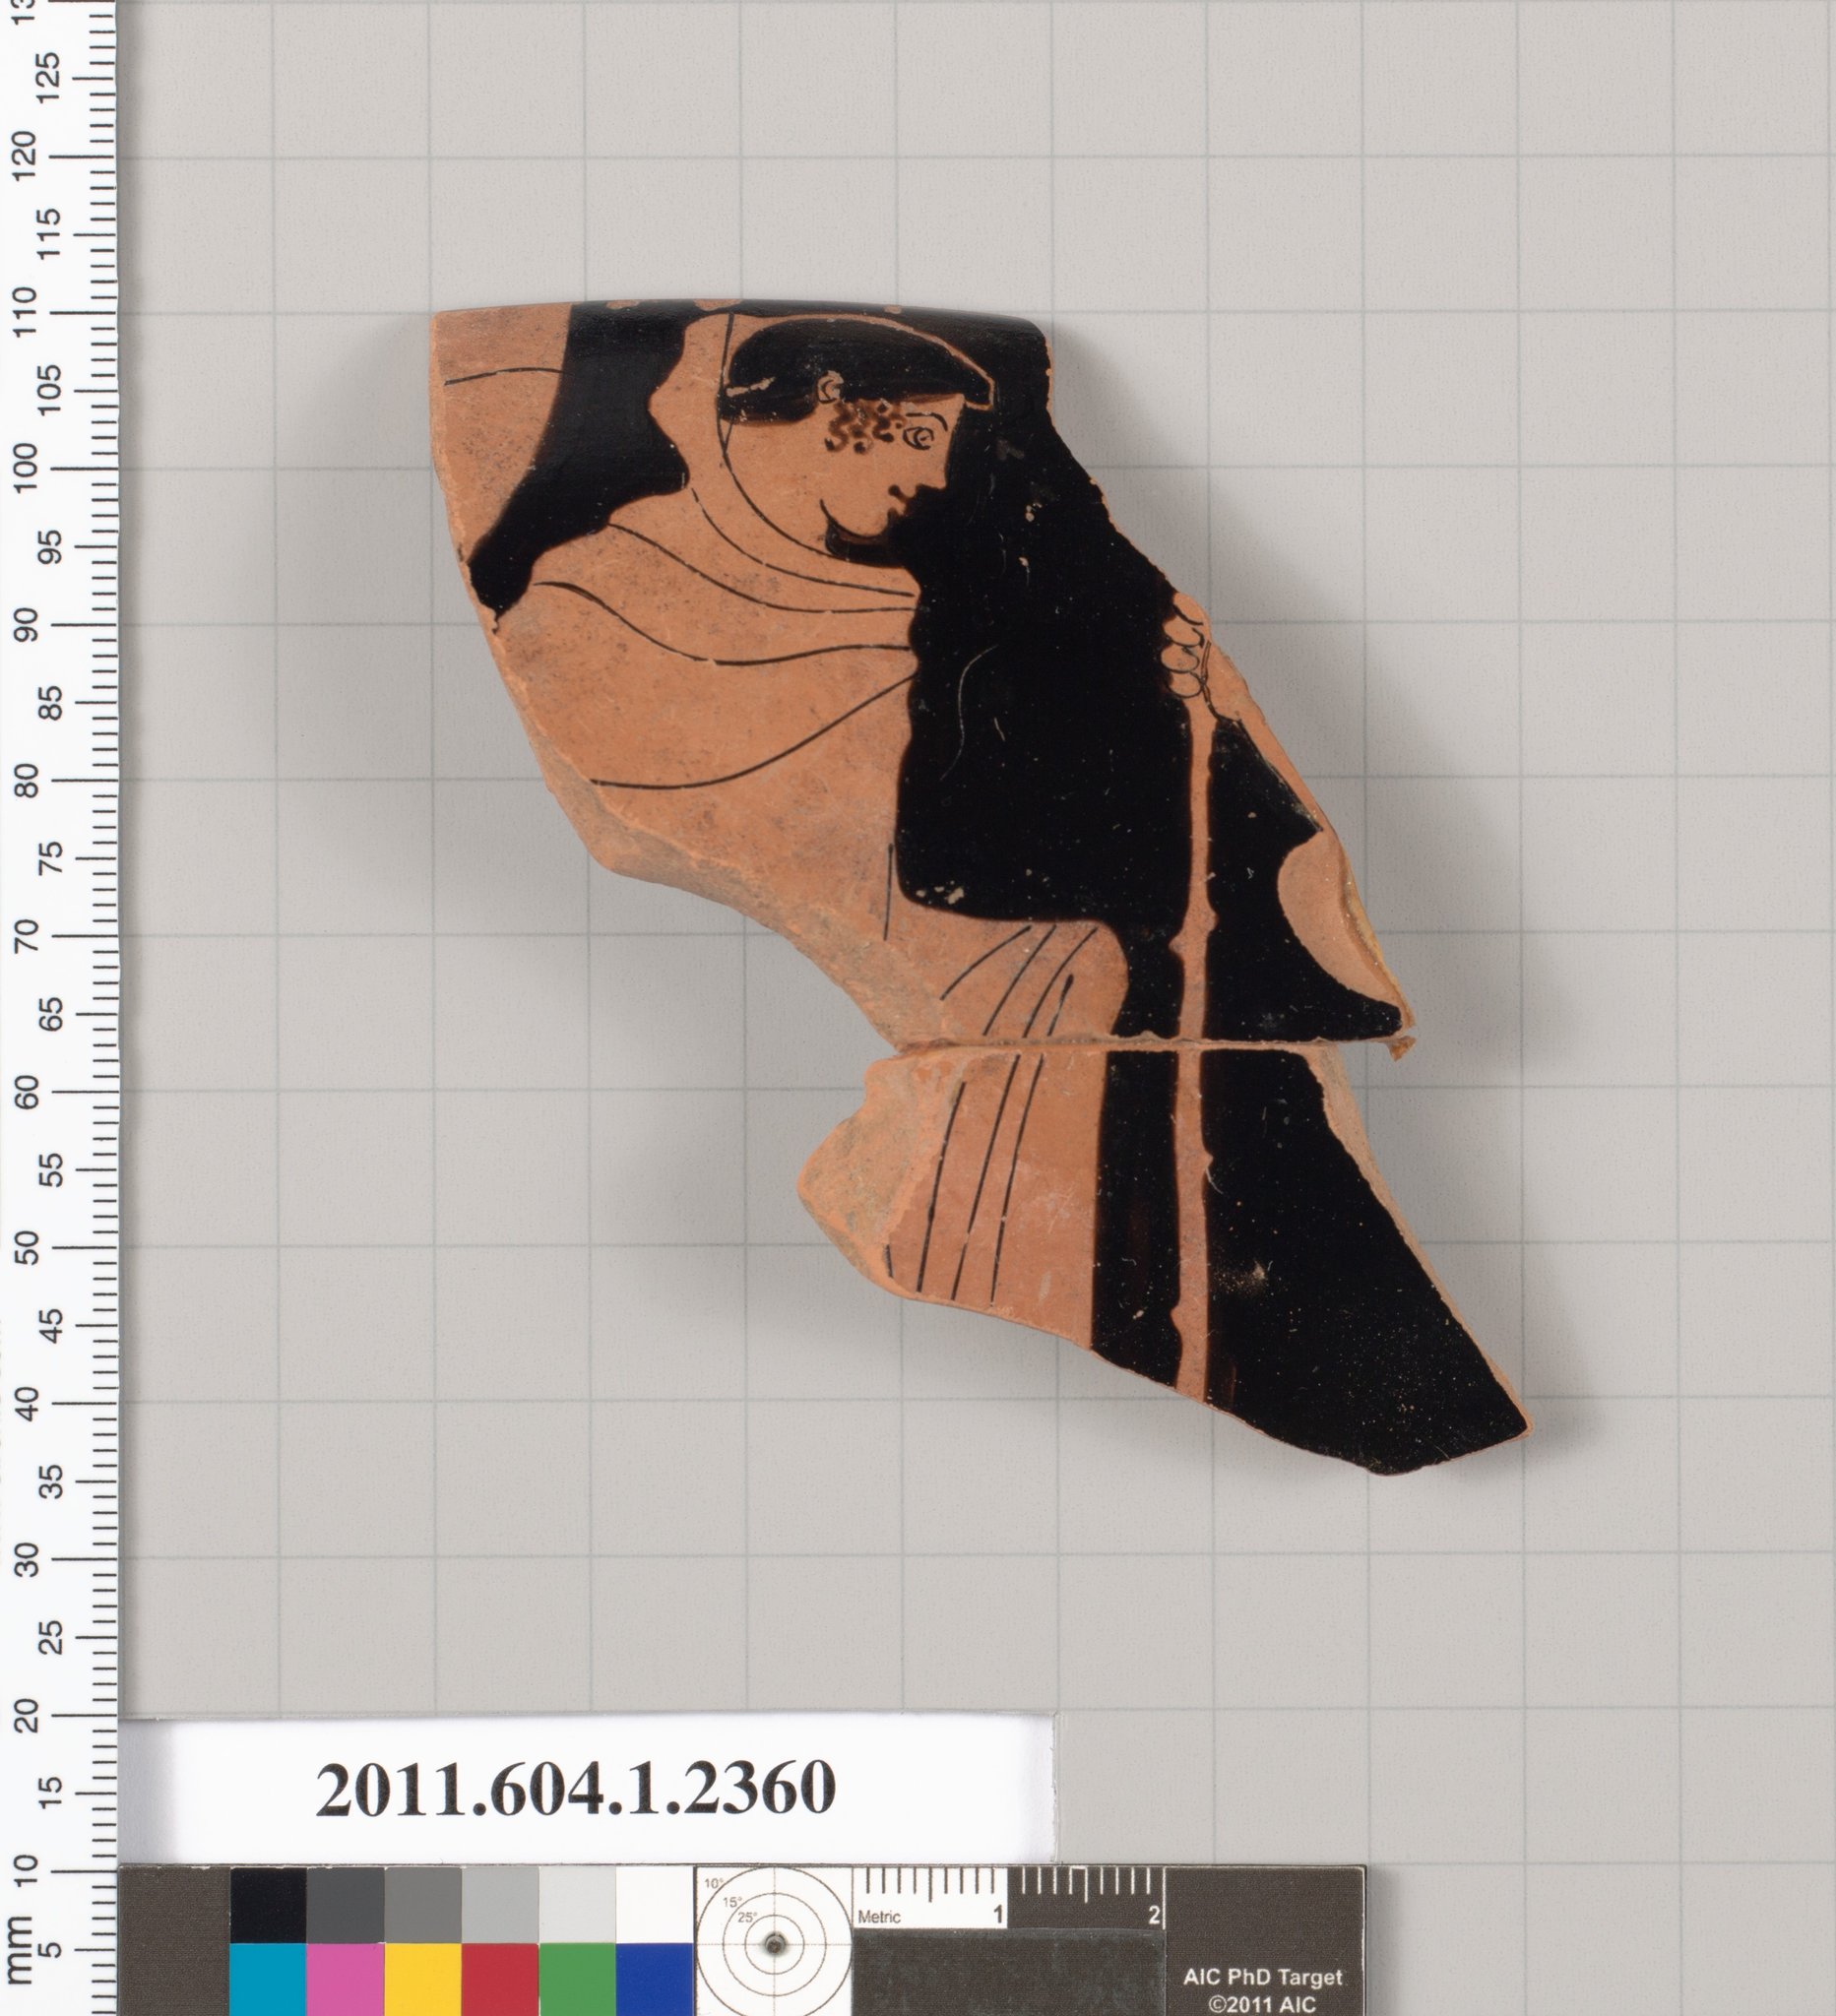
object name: kylix fragment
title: Terracotta rim fragment of a kylix (drinking cup)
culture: greek, attic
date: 470-460 BCE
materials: terracotta